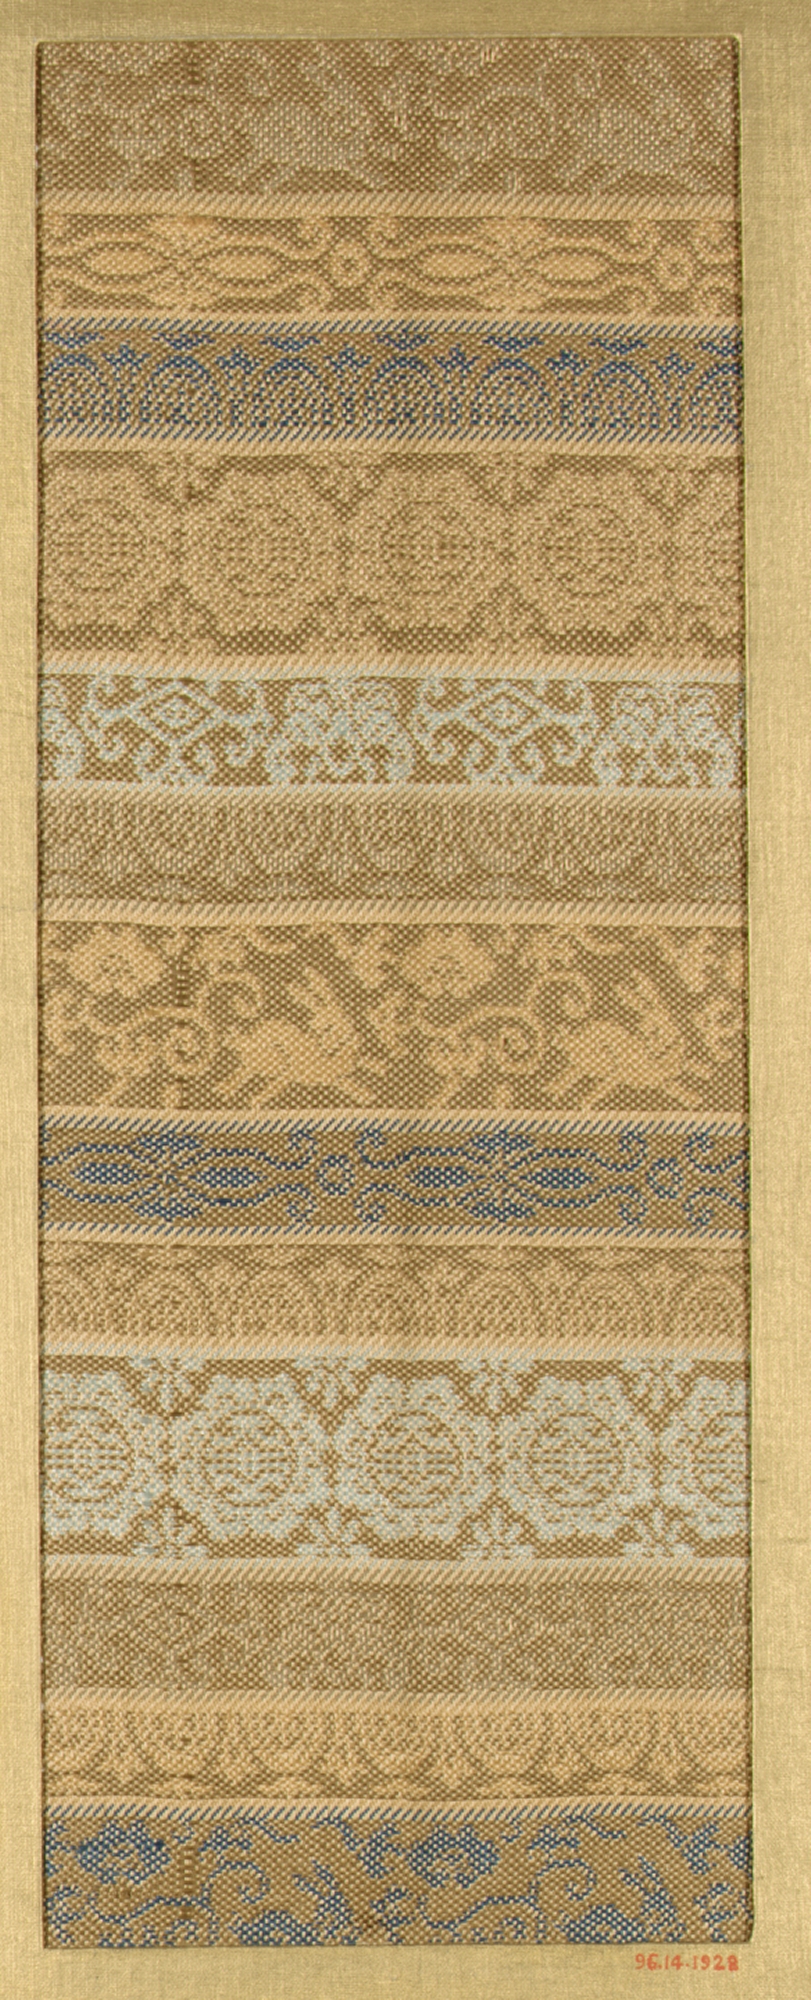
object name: piece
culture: japanese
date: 1701-1900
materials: silk